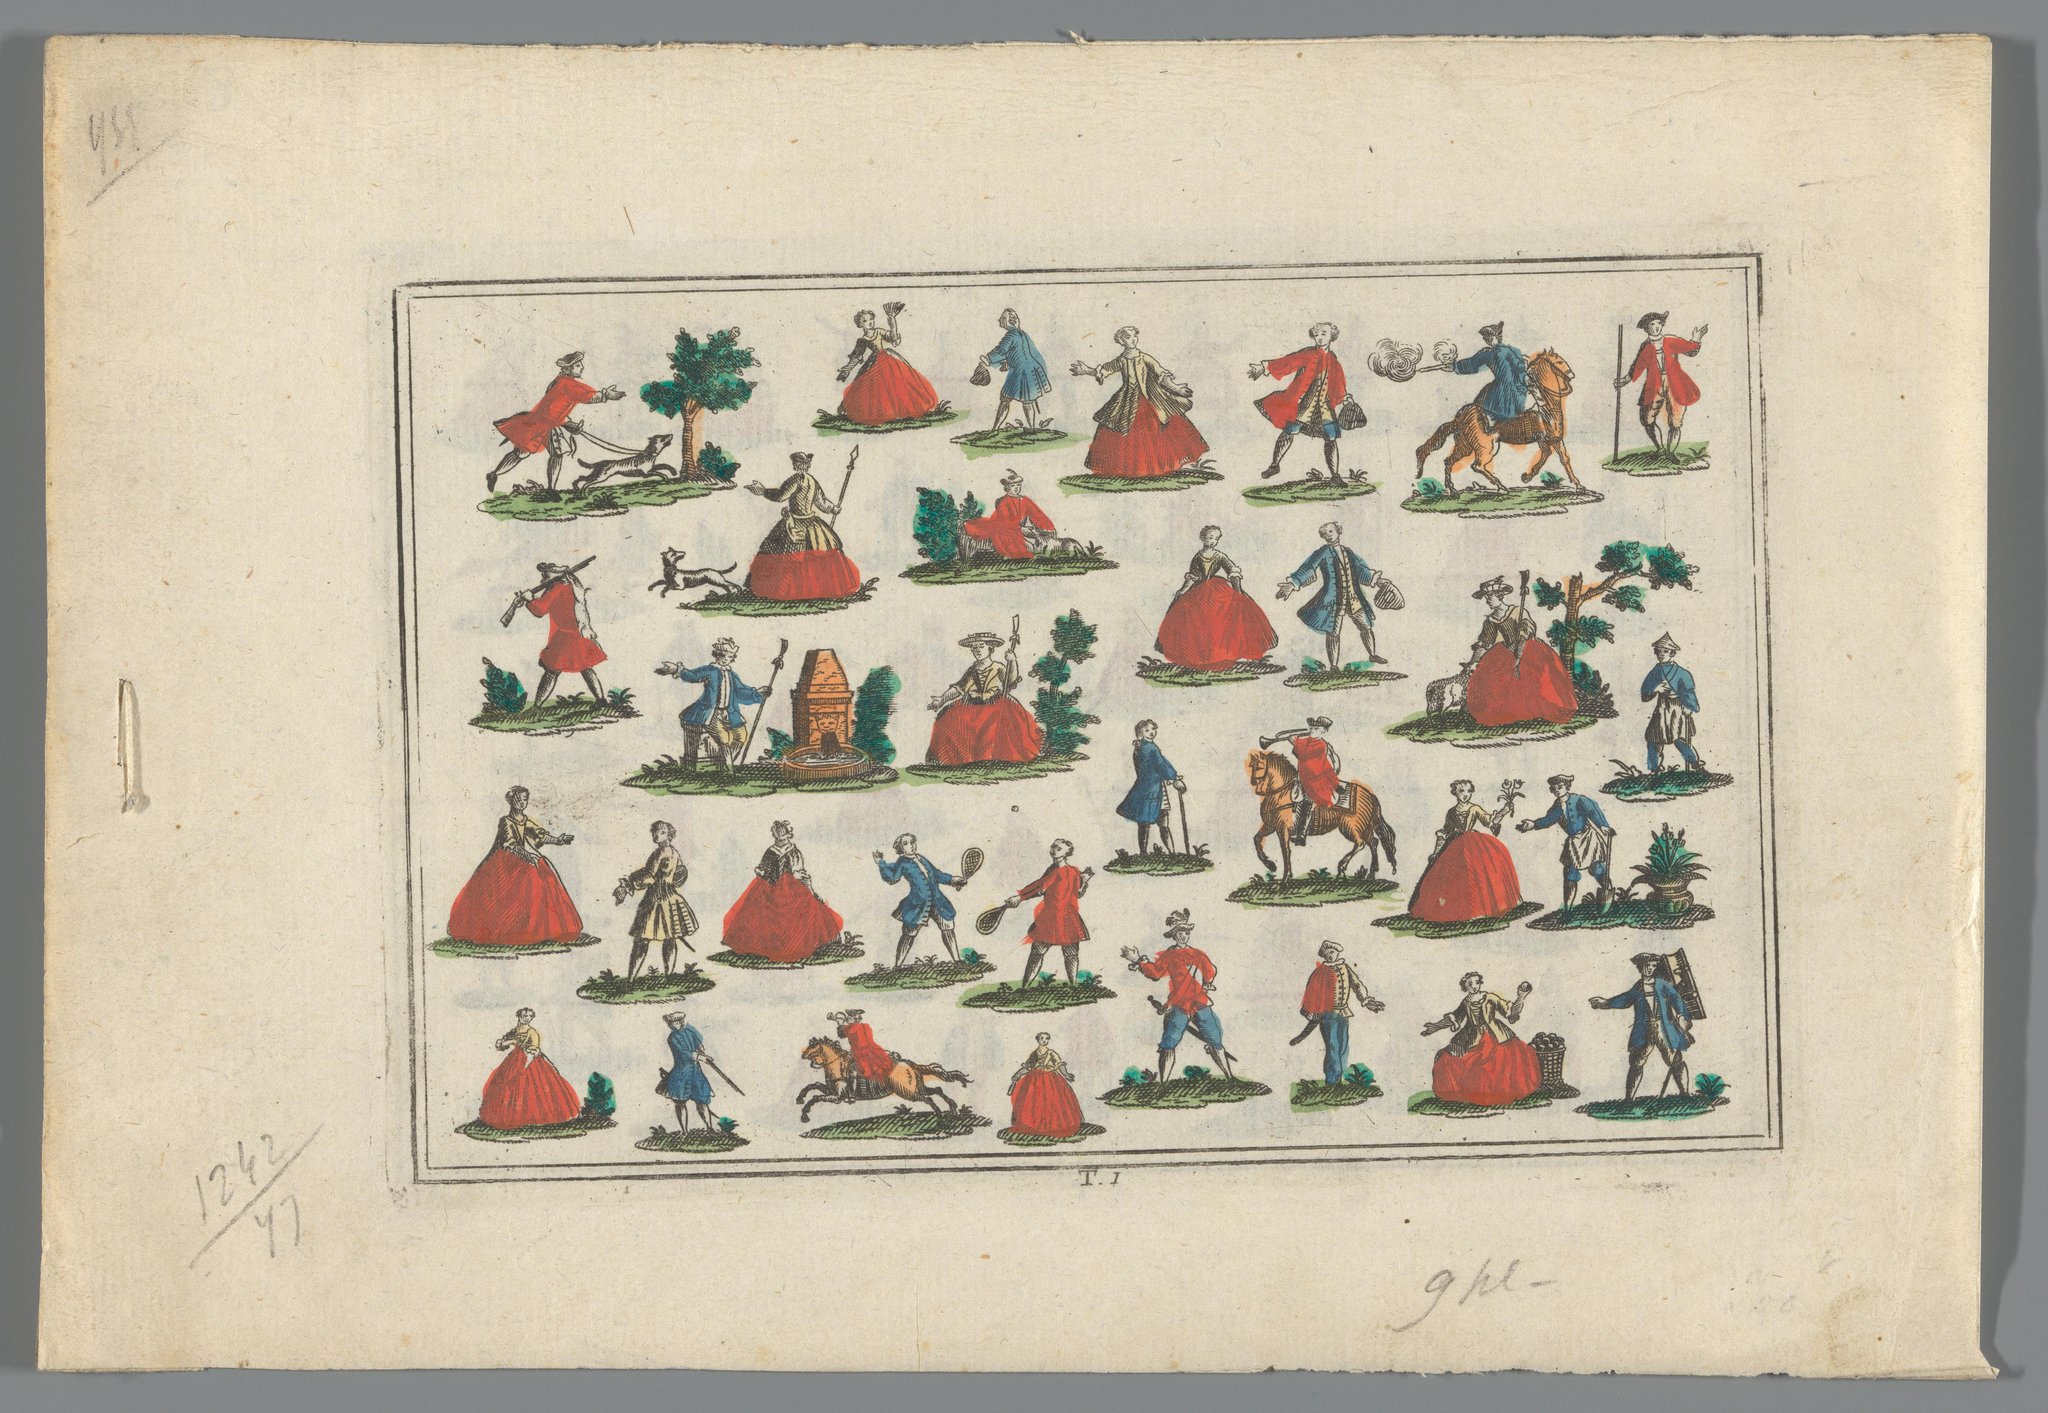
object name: print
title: Dames en heren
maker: Anonymous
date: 1750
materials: paper, watercolor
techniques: etching, hand coloring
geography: paris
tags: adult woman, adult man, clothes, costume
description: Blad met galante dames en heren, in verschillende bezigheden. Midden onder genummerd: T. I. Een van 39 bladen met knipplaatjes en decoratieve randen.